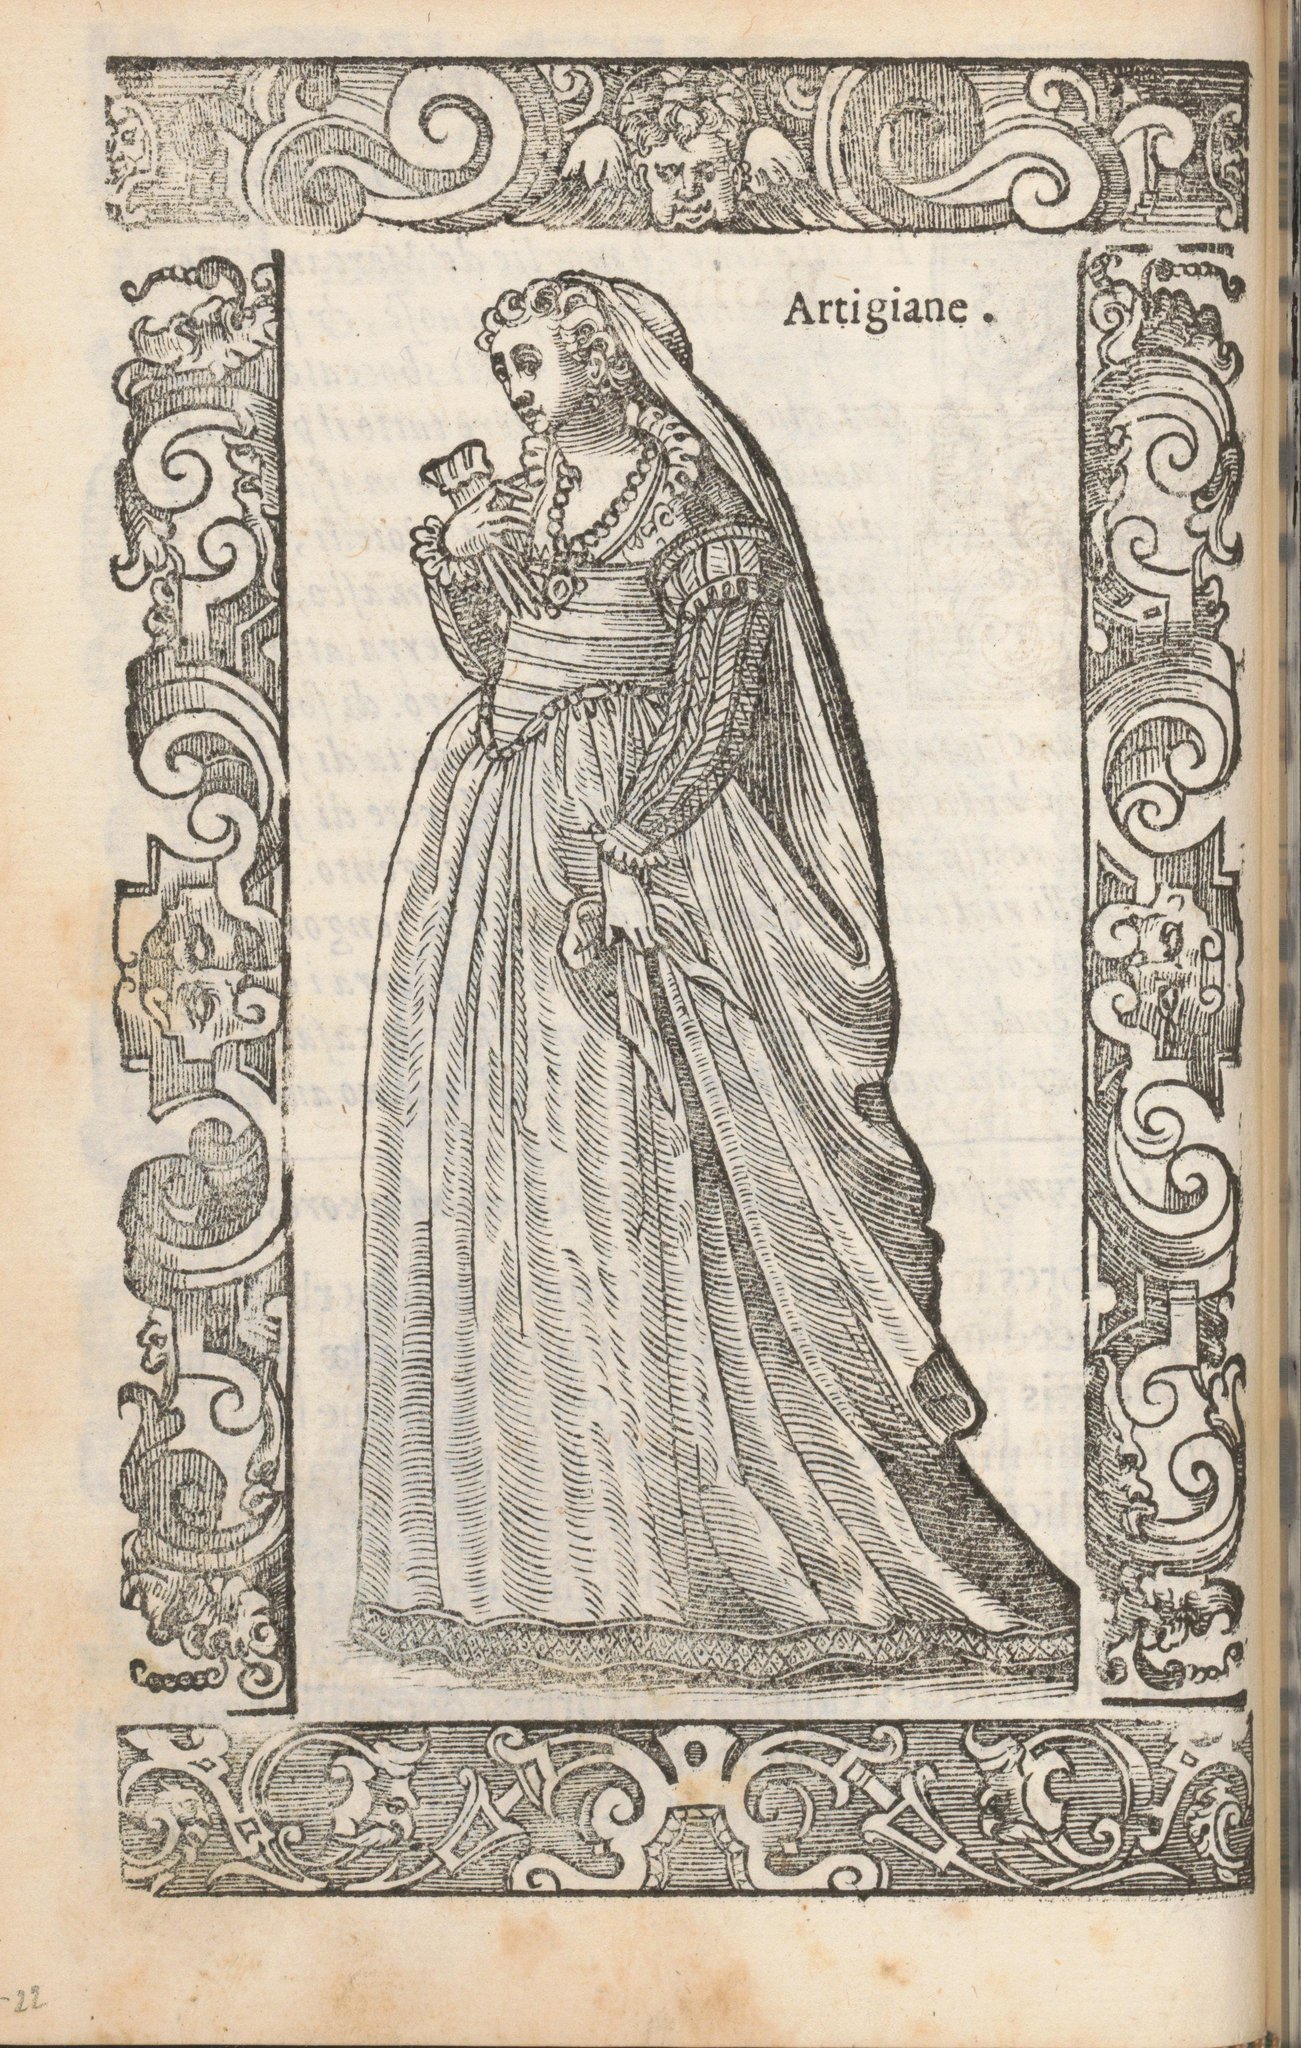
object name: costume print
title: Habiti antichi, et moderni di tutto il mondo : di nuovo accresciuti di molte figure : vestitus antiquorum, recentiorumque totius orbis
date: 1598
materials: paper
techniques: woodcut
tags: gloves, mittens (short gloves) (+ women's clothes), fashion plates, dress, gown (+ women's clothes), necklace (+ women's clothes), clothing for the upper part of the body (with name) (+ women's clothes)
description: De vrouw van een ambachtsman die, vanwege de regels wat standsverschil betreft, eenvoudiger gekleed gaat dan de adellijke dame. Lijfje en rok zijn van goedkopere stof. Zijden sluier over het hoofd. Ketting van bloedkoraal; handschoen in de hand. In ornamentrand